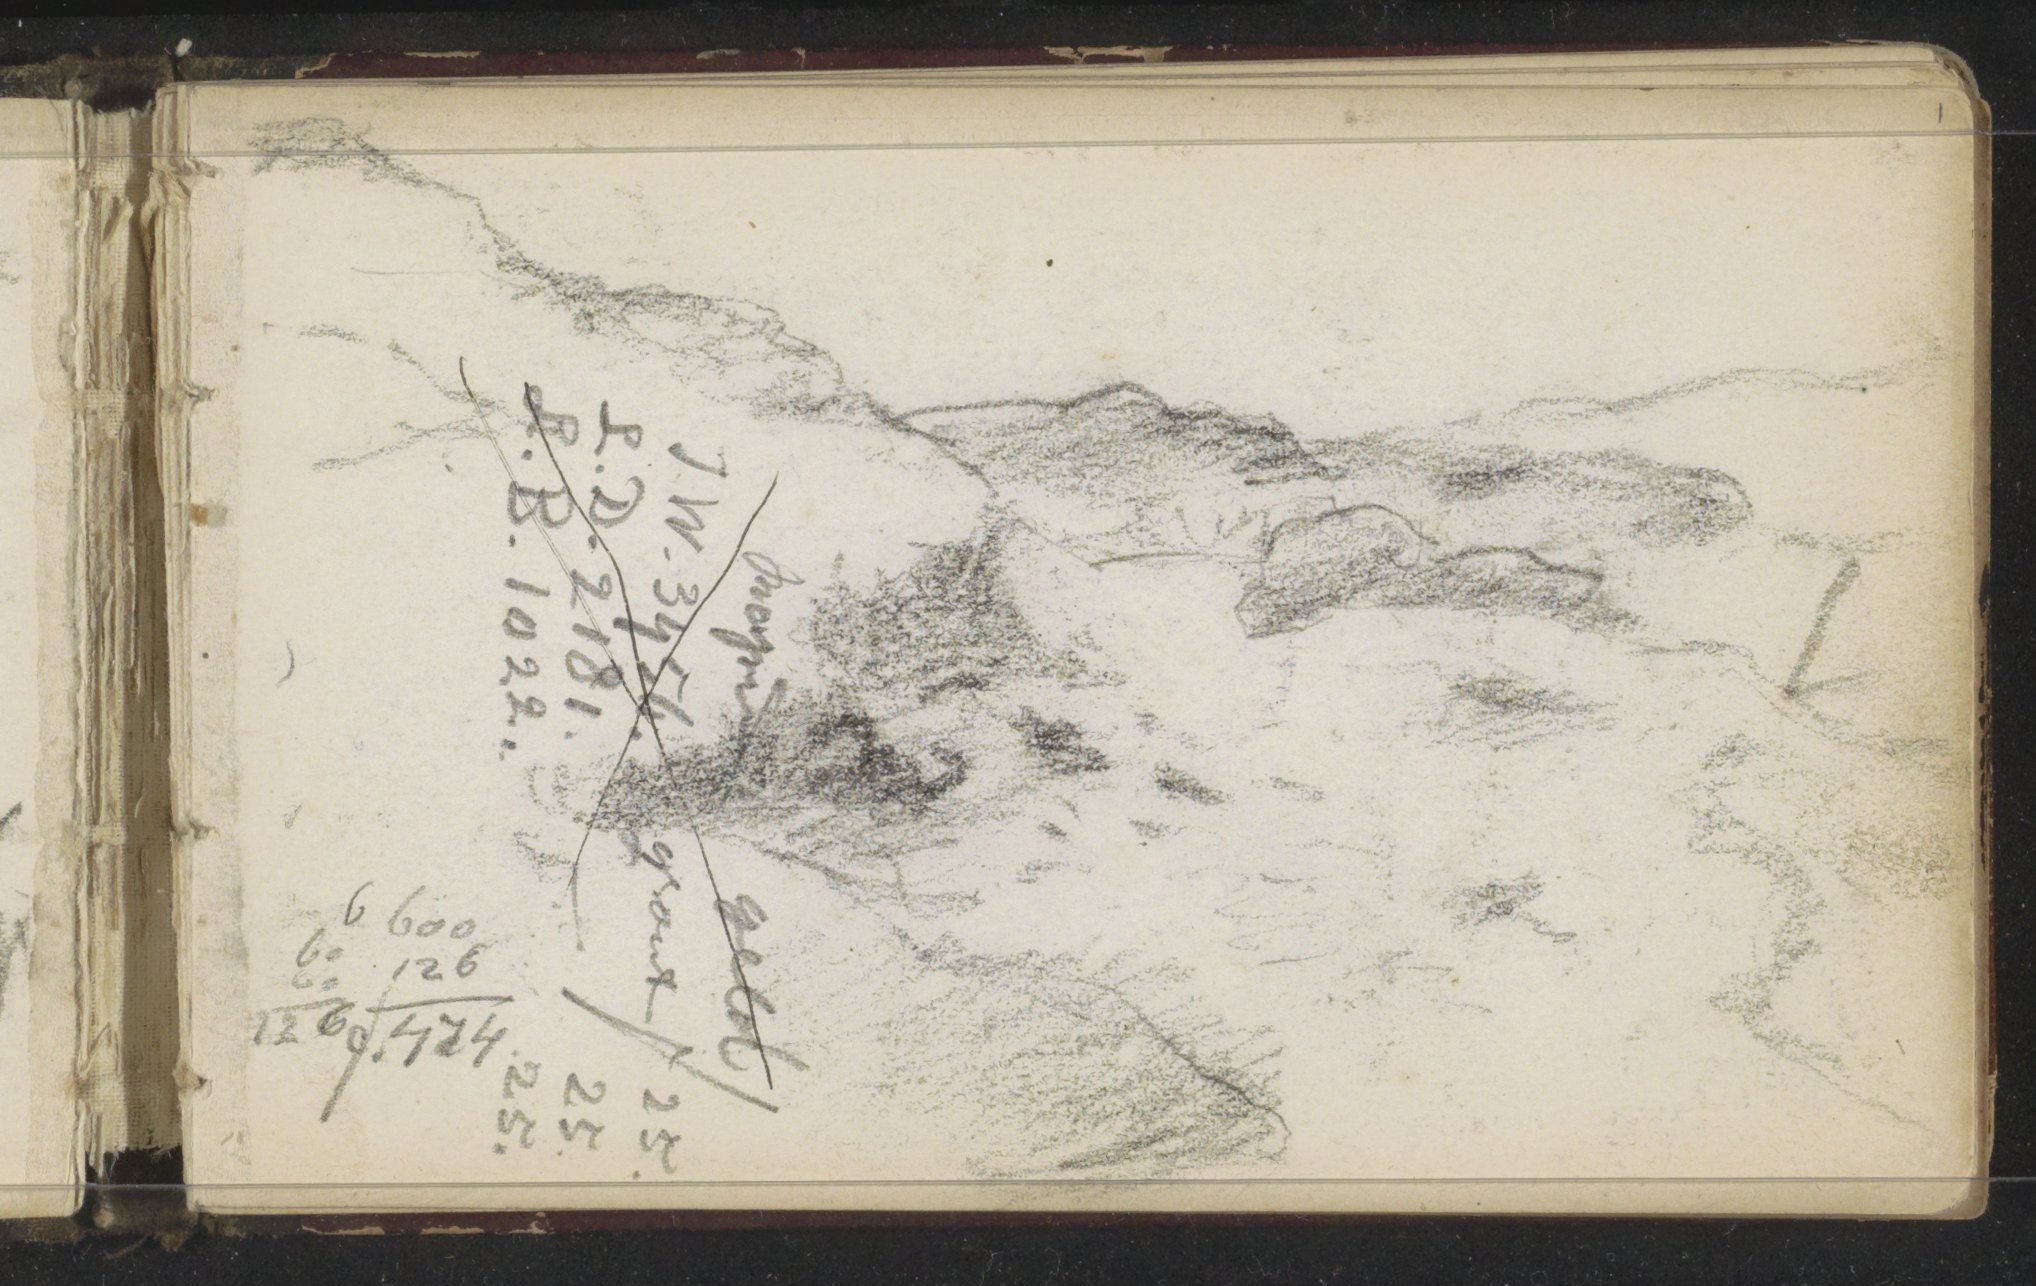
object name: sketchbook leaf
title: Heuvellandschap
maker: willem cornelis rip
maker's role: draughtsman, painter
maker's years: 1856-1922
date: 1891-1892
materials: chalk, paper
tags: low hill country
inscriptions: annotation: ‘[...]/ geld/ J.W. 3456 [...]’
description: Blad 1 recto uit een schetsboek met 28 bladen.